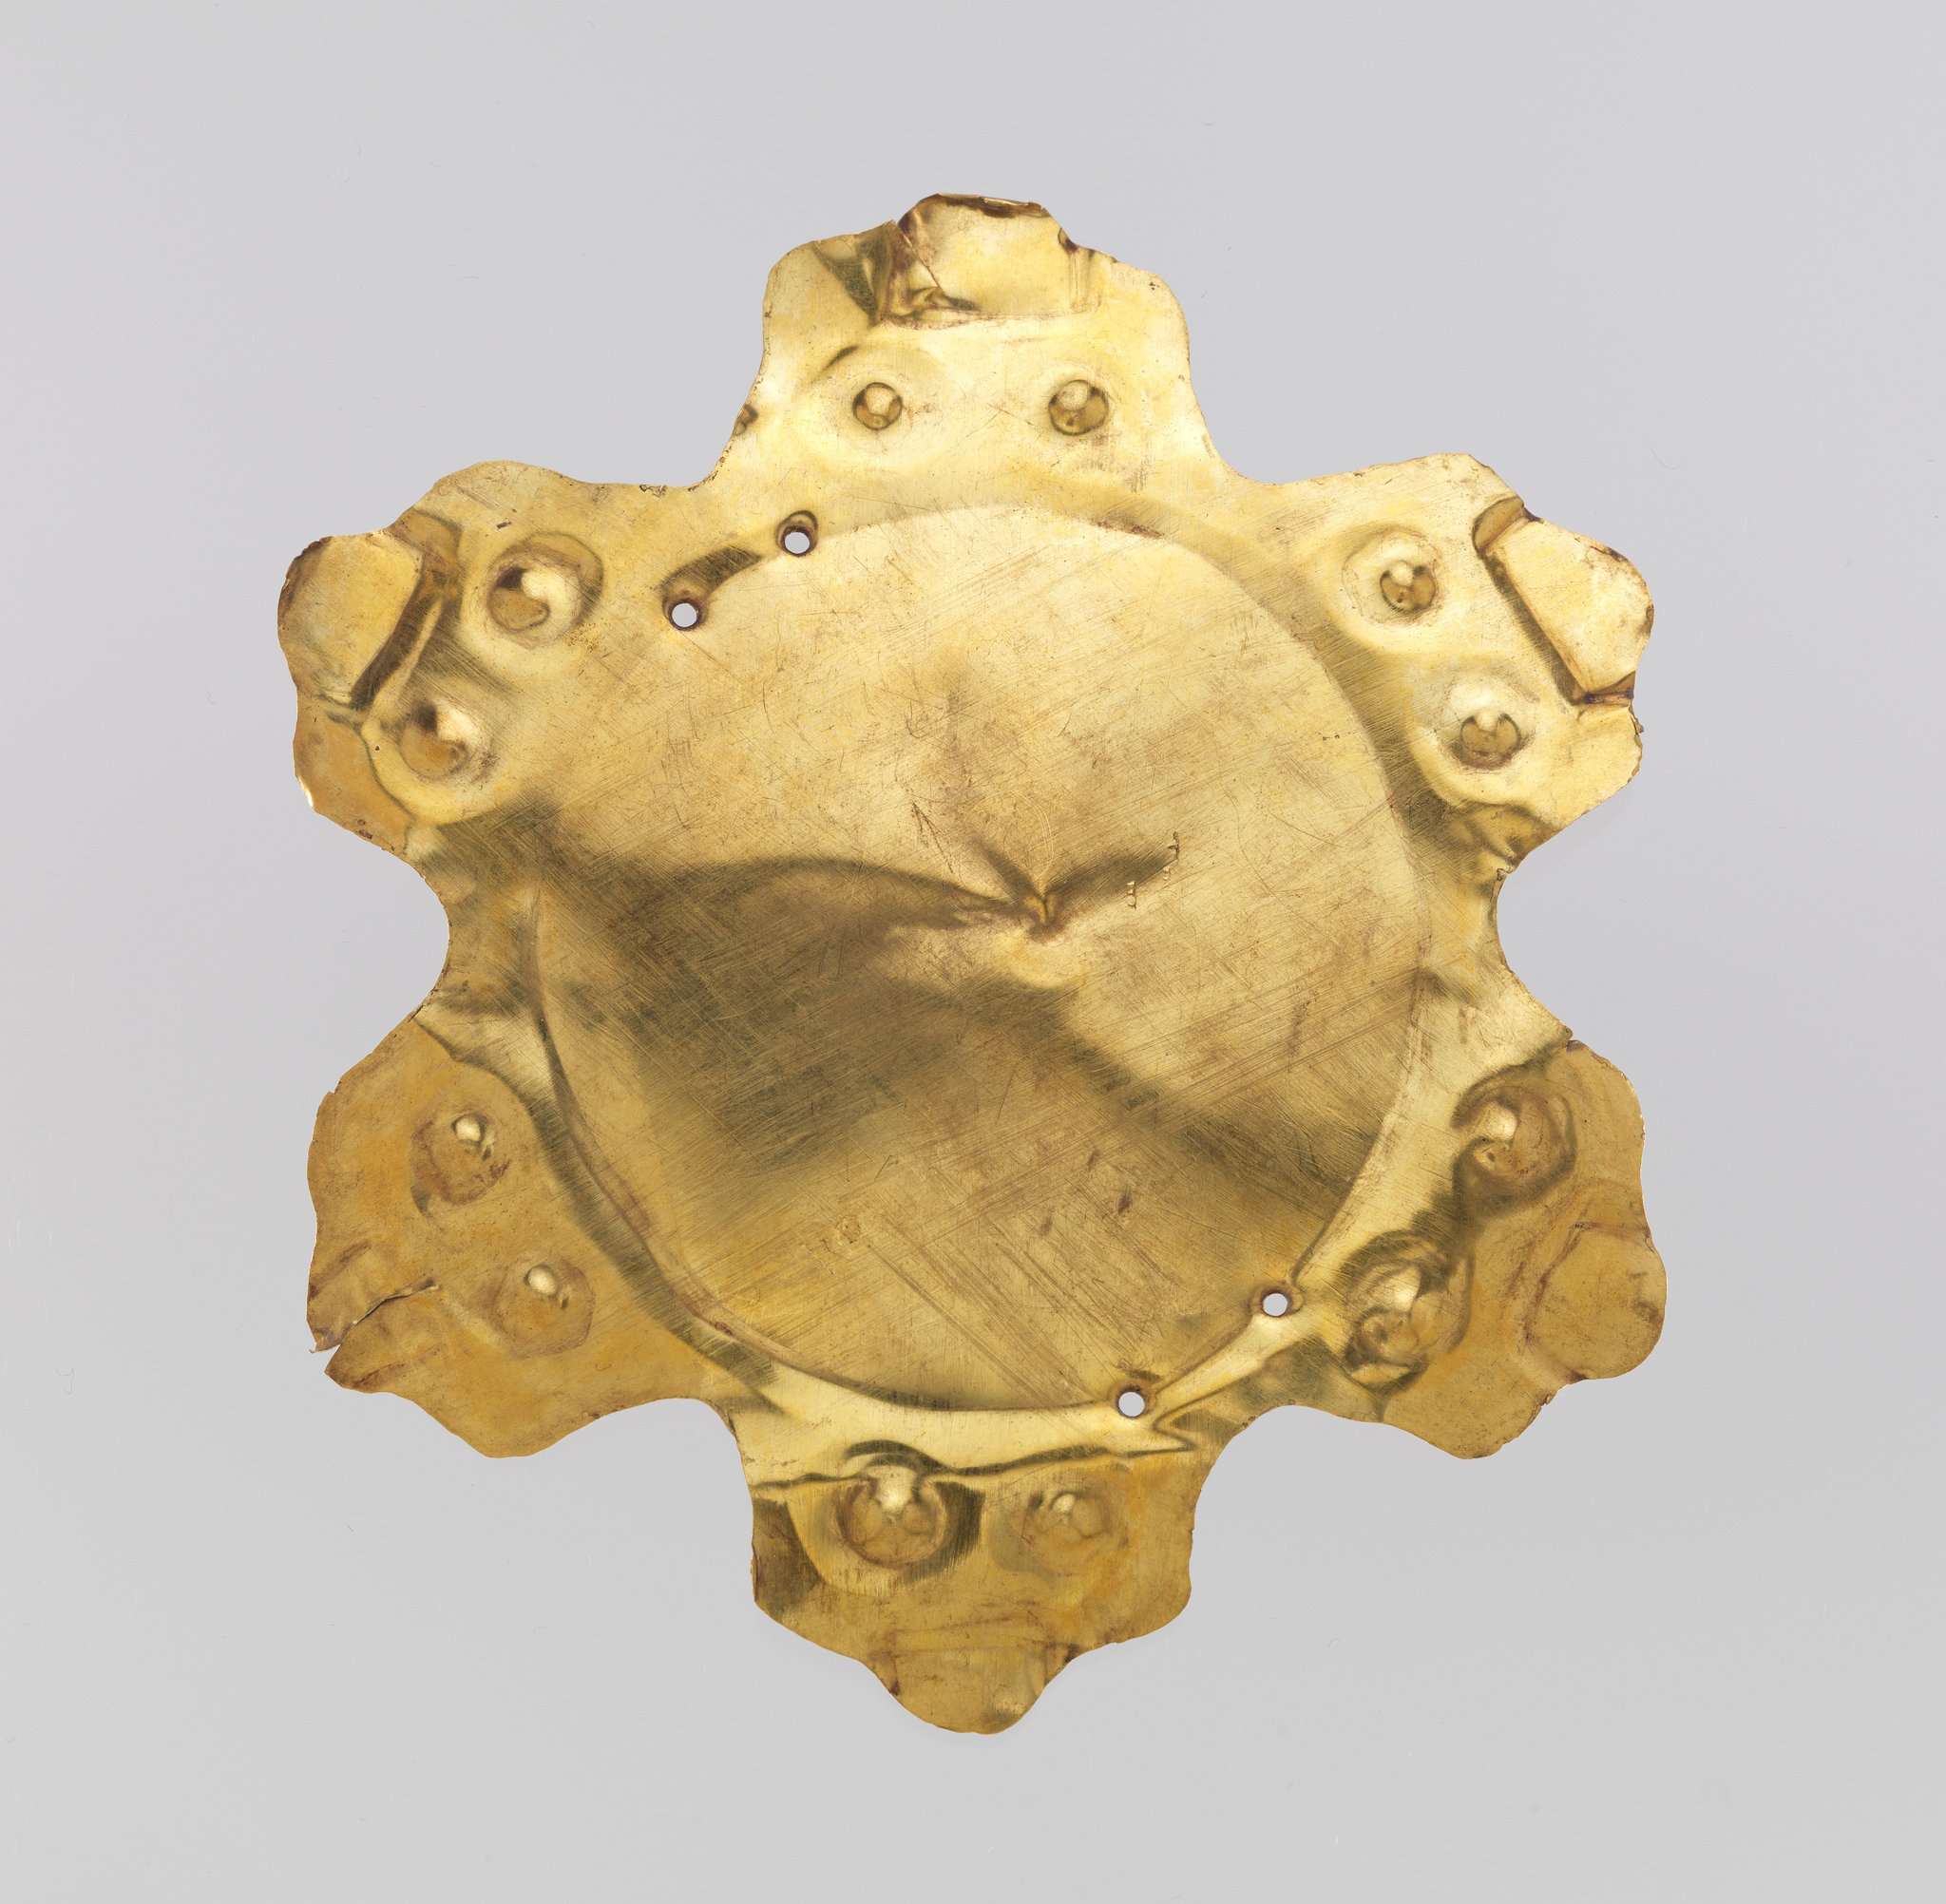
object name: ornament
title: Textile ornament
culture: nasca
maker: nasca artist(s)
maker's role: artist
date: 1-700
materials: gold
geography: peru